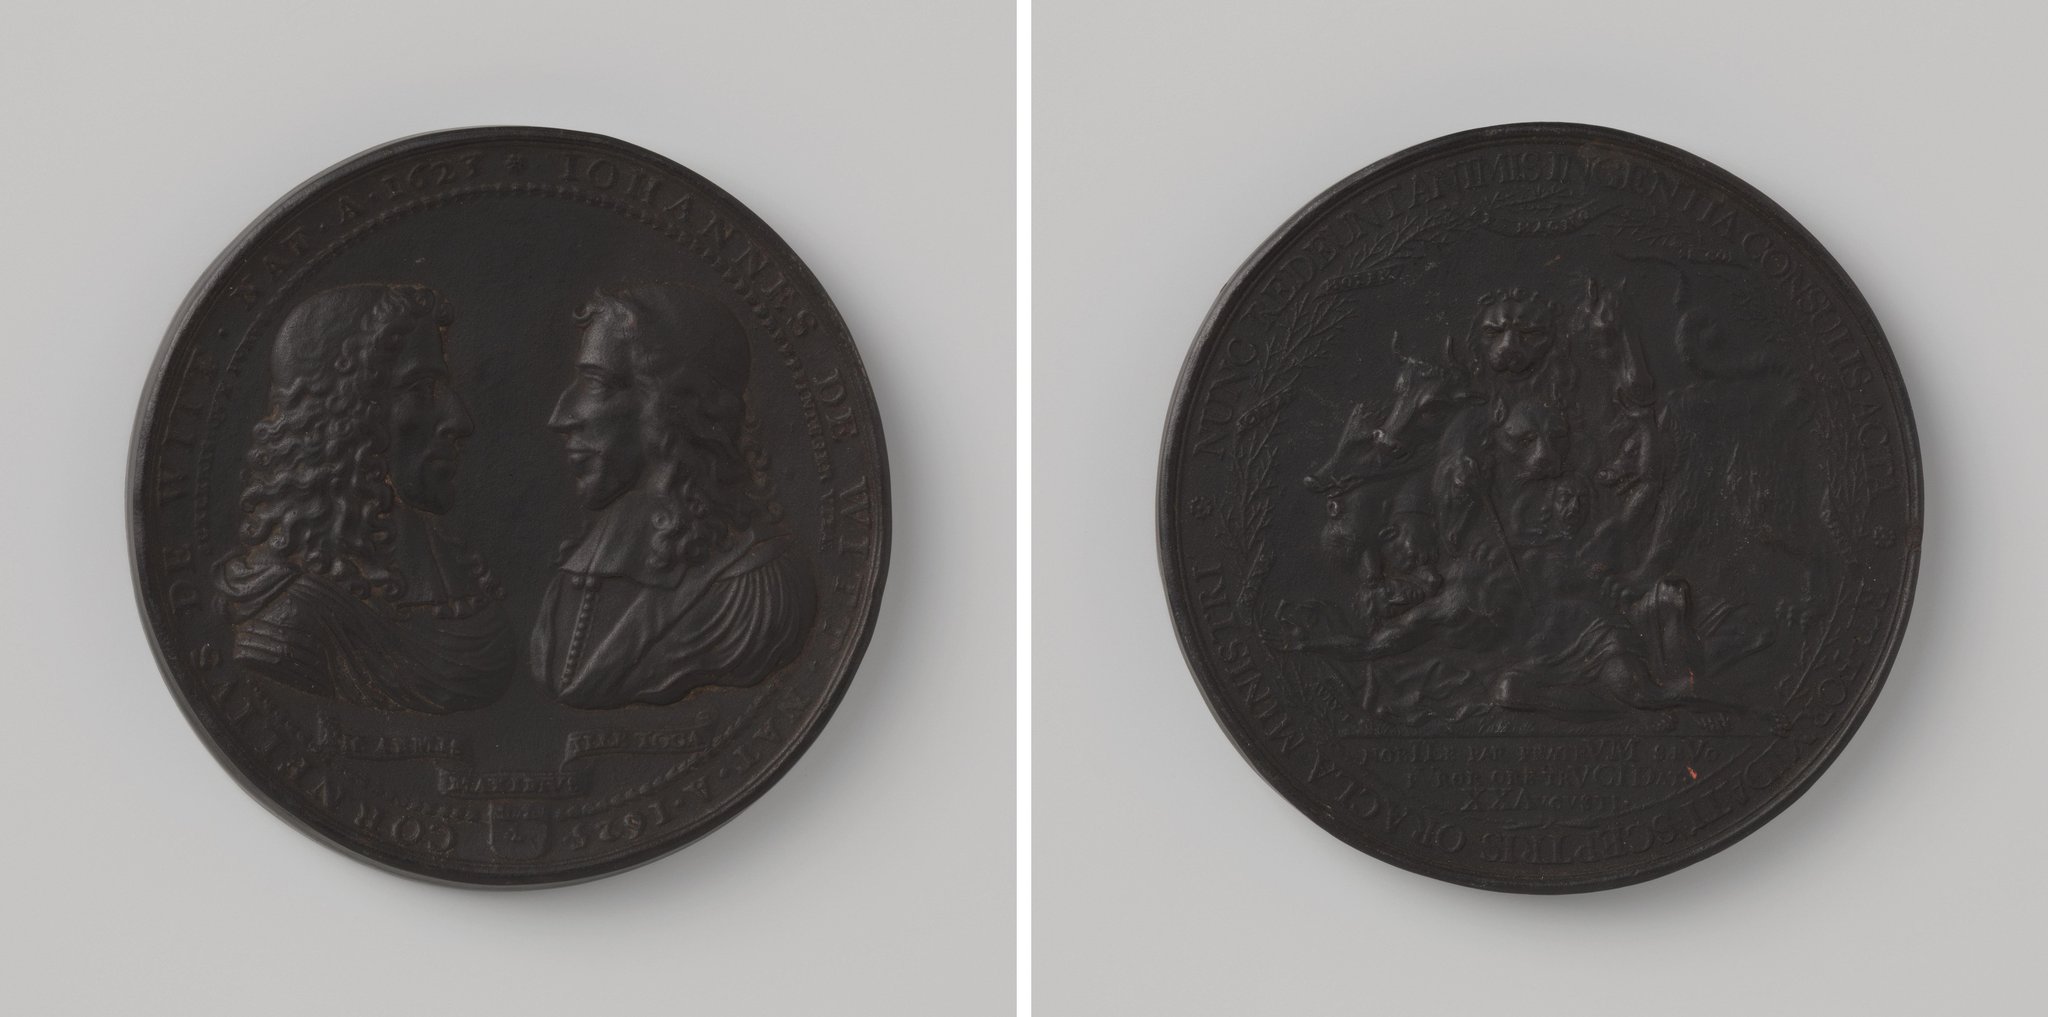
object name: history medal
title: Moord op Johan en Cornelis de Witt te Den Haag 1672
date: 1672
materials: terracotta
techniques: casting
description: Penning afgegoten in terracotta, op de voorzijde de elkaar aanziende portretten van Johan en Cornelis de Witt, waaronder een wapenschildje en een lint met tekst, met omschrift, op de keerzijde een monster met vele dierenhoofden dat de gebroeders belaagt, met omschrift en afsnedetekst.